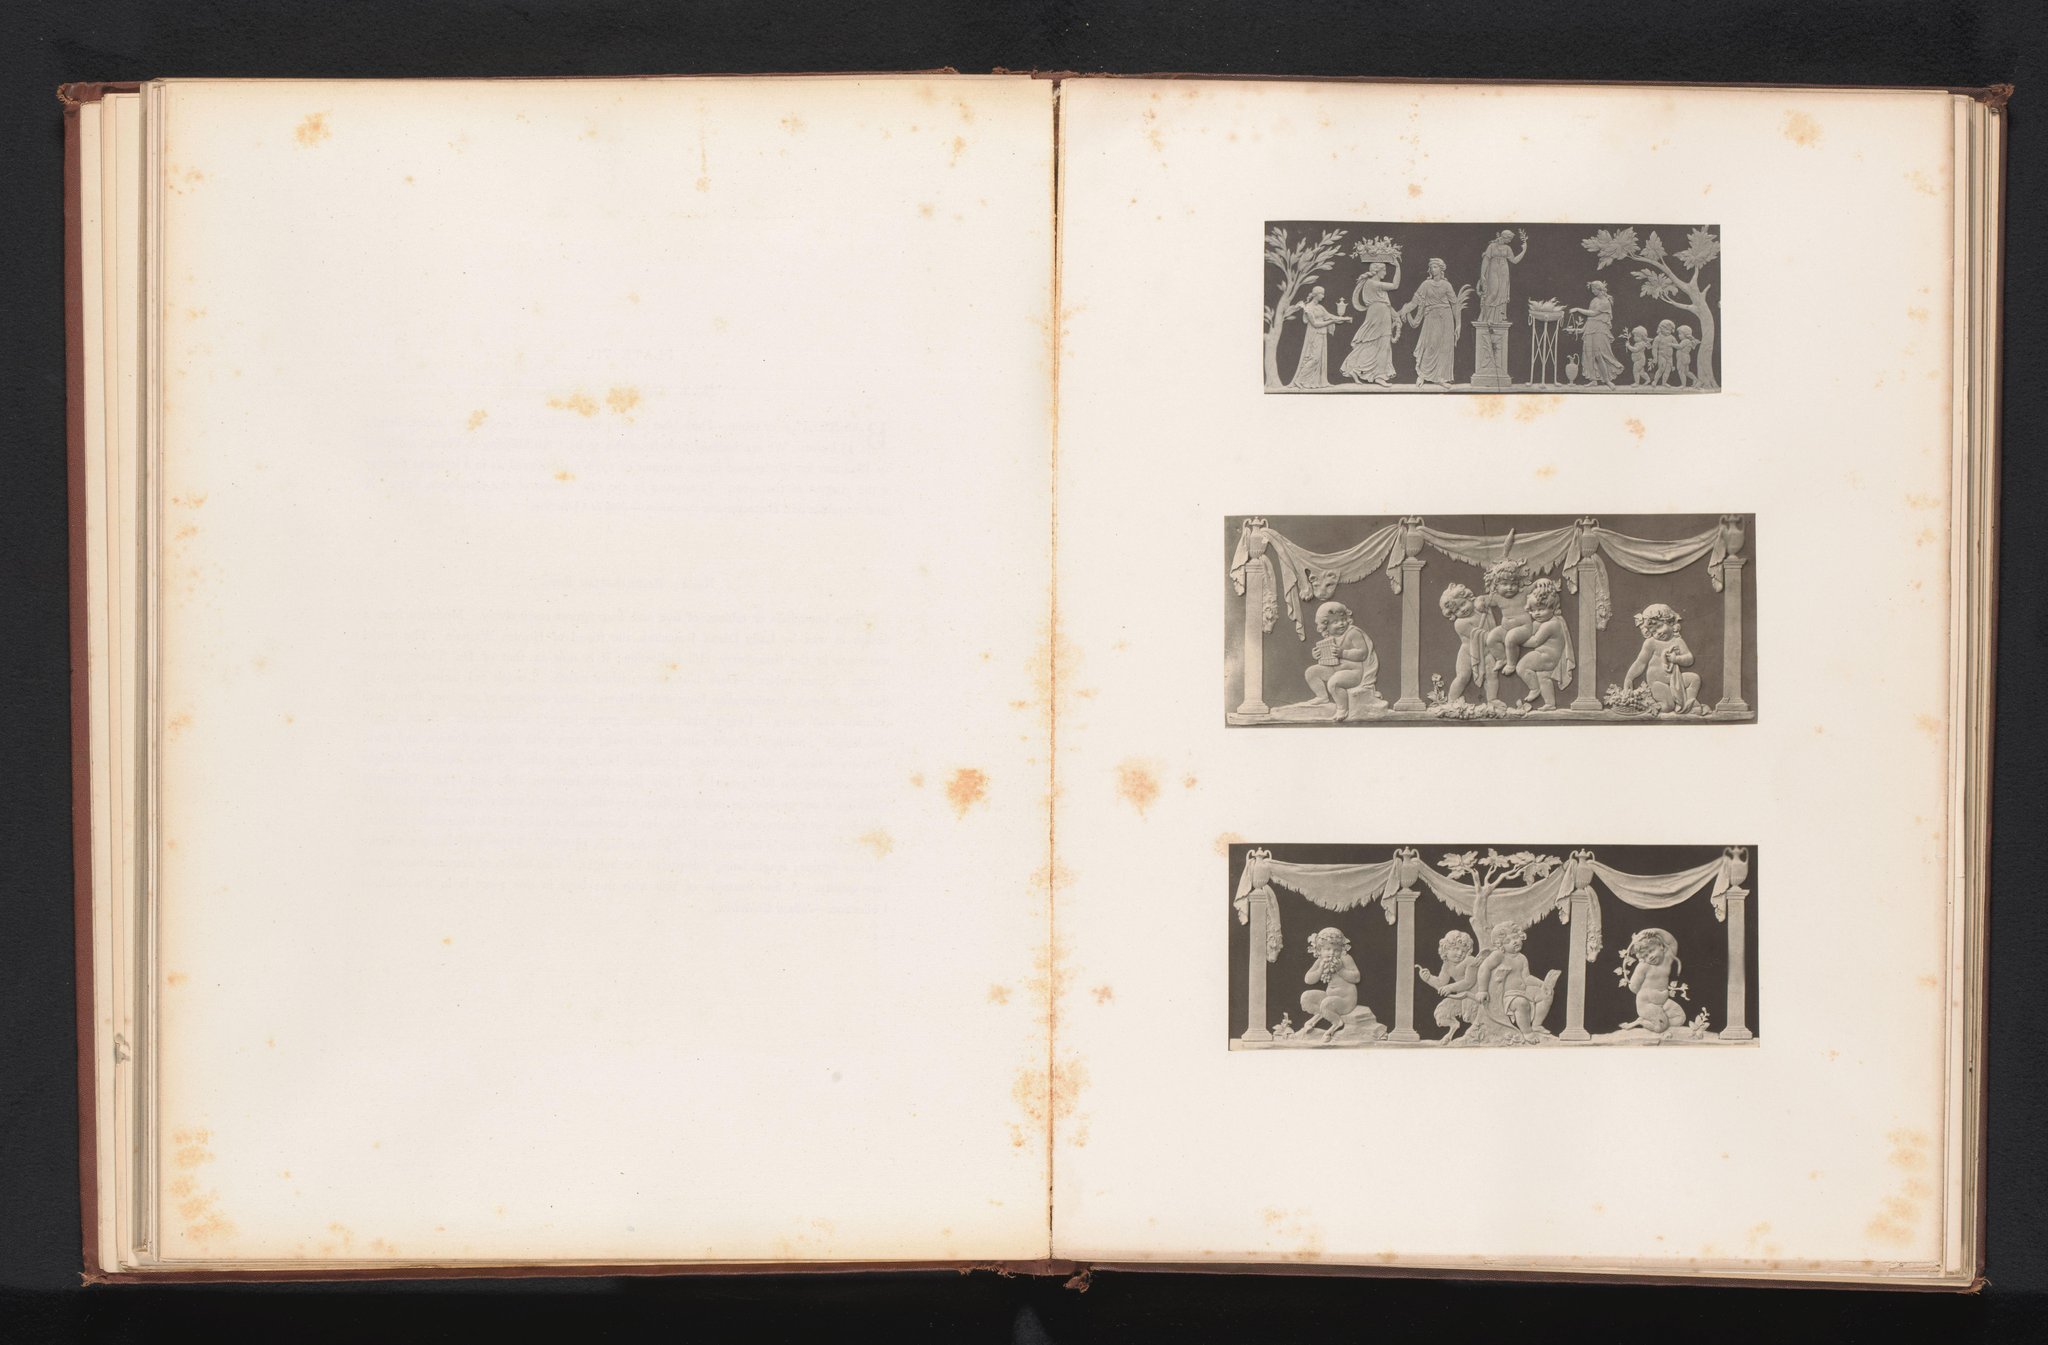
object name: page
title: Bas-reliëfs van een offer voor Ceres en bacchantische putti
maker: joseph cundall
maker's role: fotograaf, schrijver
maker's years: 1818-1895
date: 1868-1873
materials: paper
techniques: carbon print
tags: (story of) ceres (demeter), children's bacchanal, sculpture (+ relief ~ sculpture)